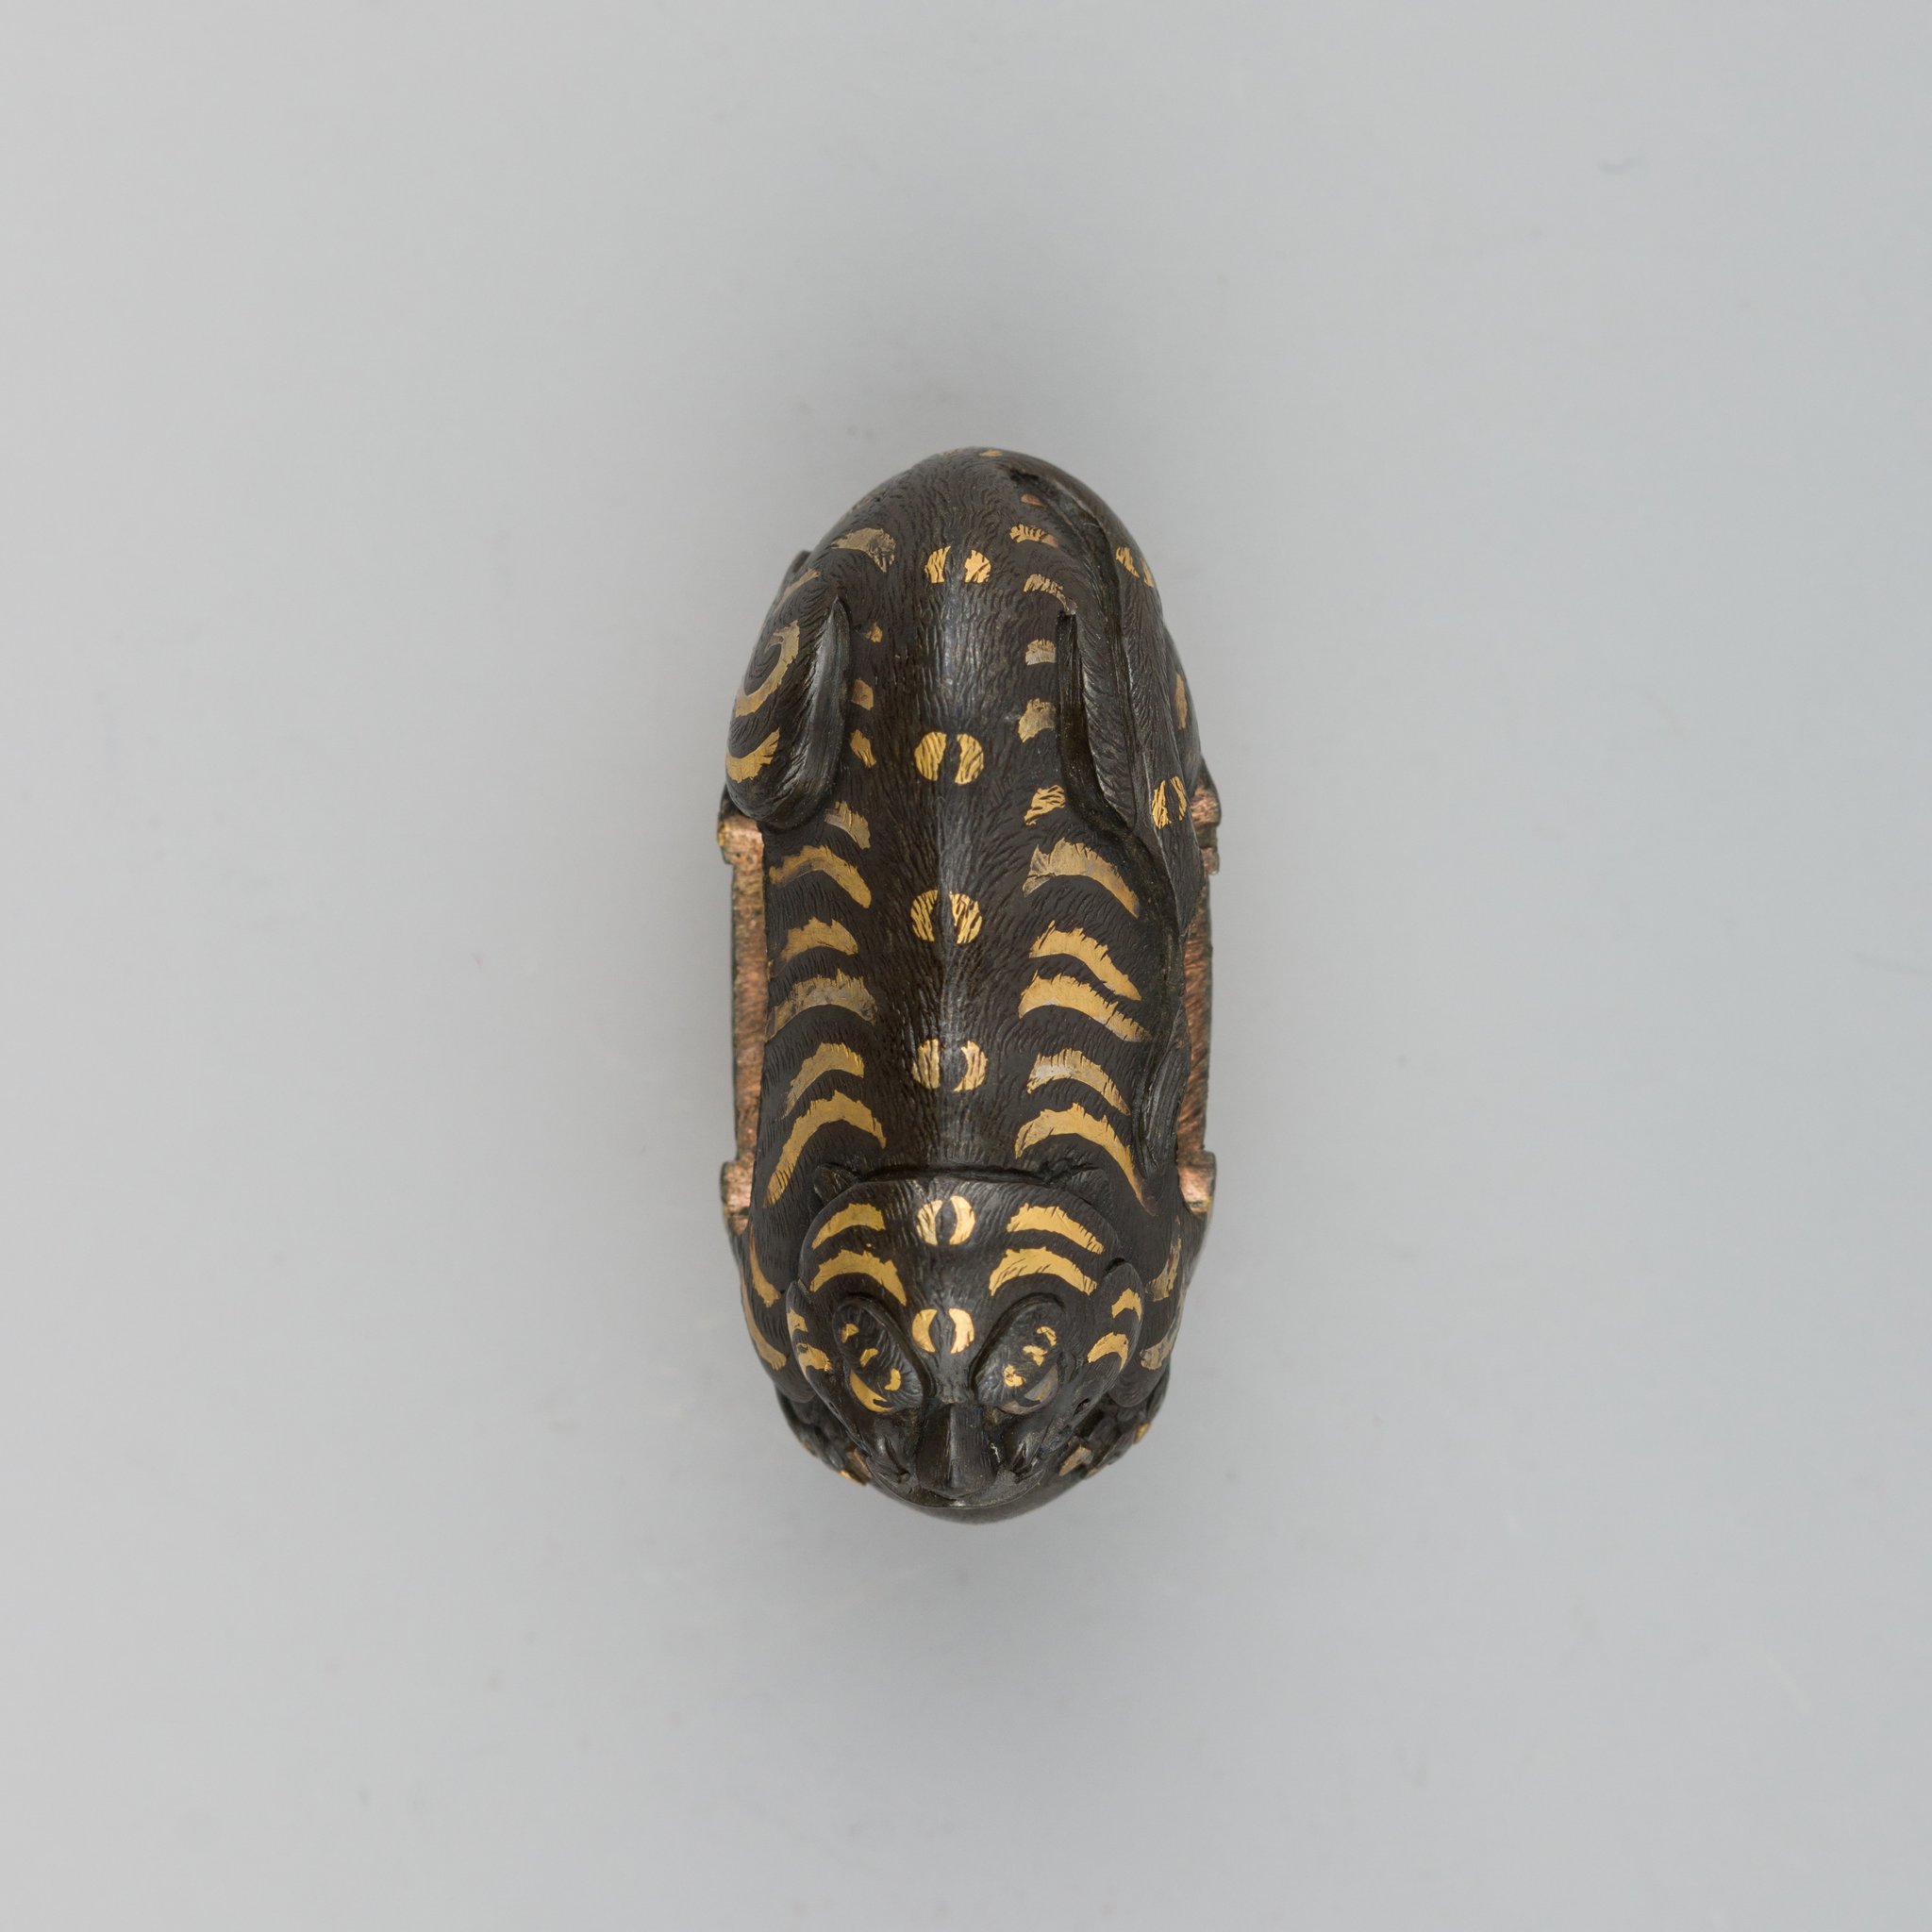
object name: sword pommel kashira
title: Sword Pommel (Kashira)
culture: japanese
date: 1615-1868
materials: silver alloy, gold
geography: japan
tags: animals